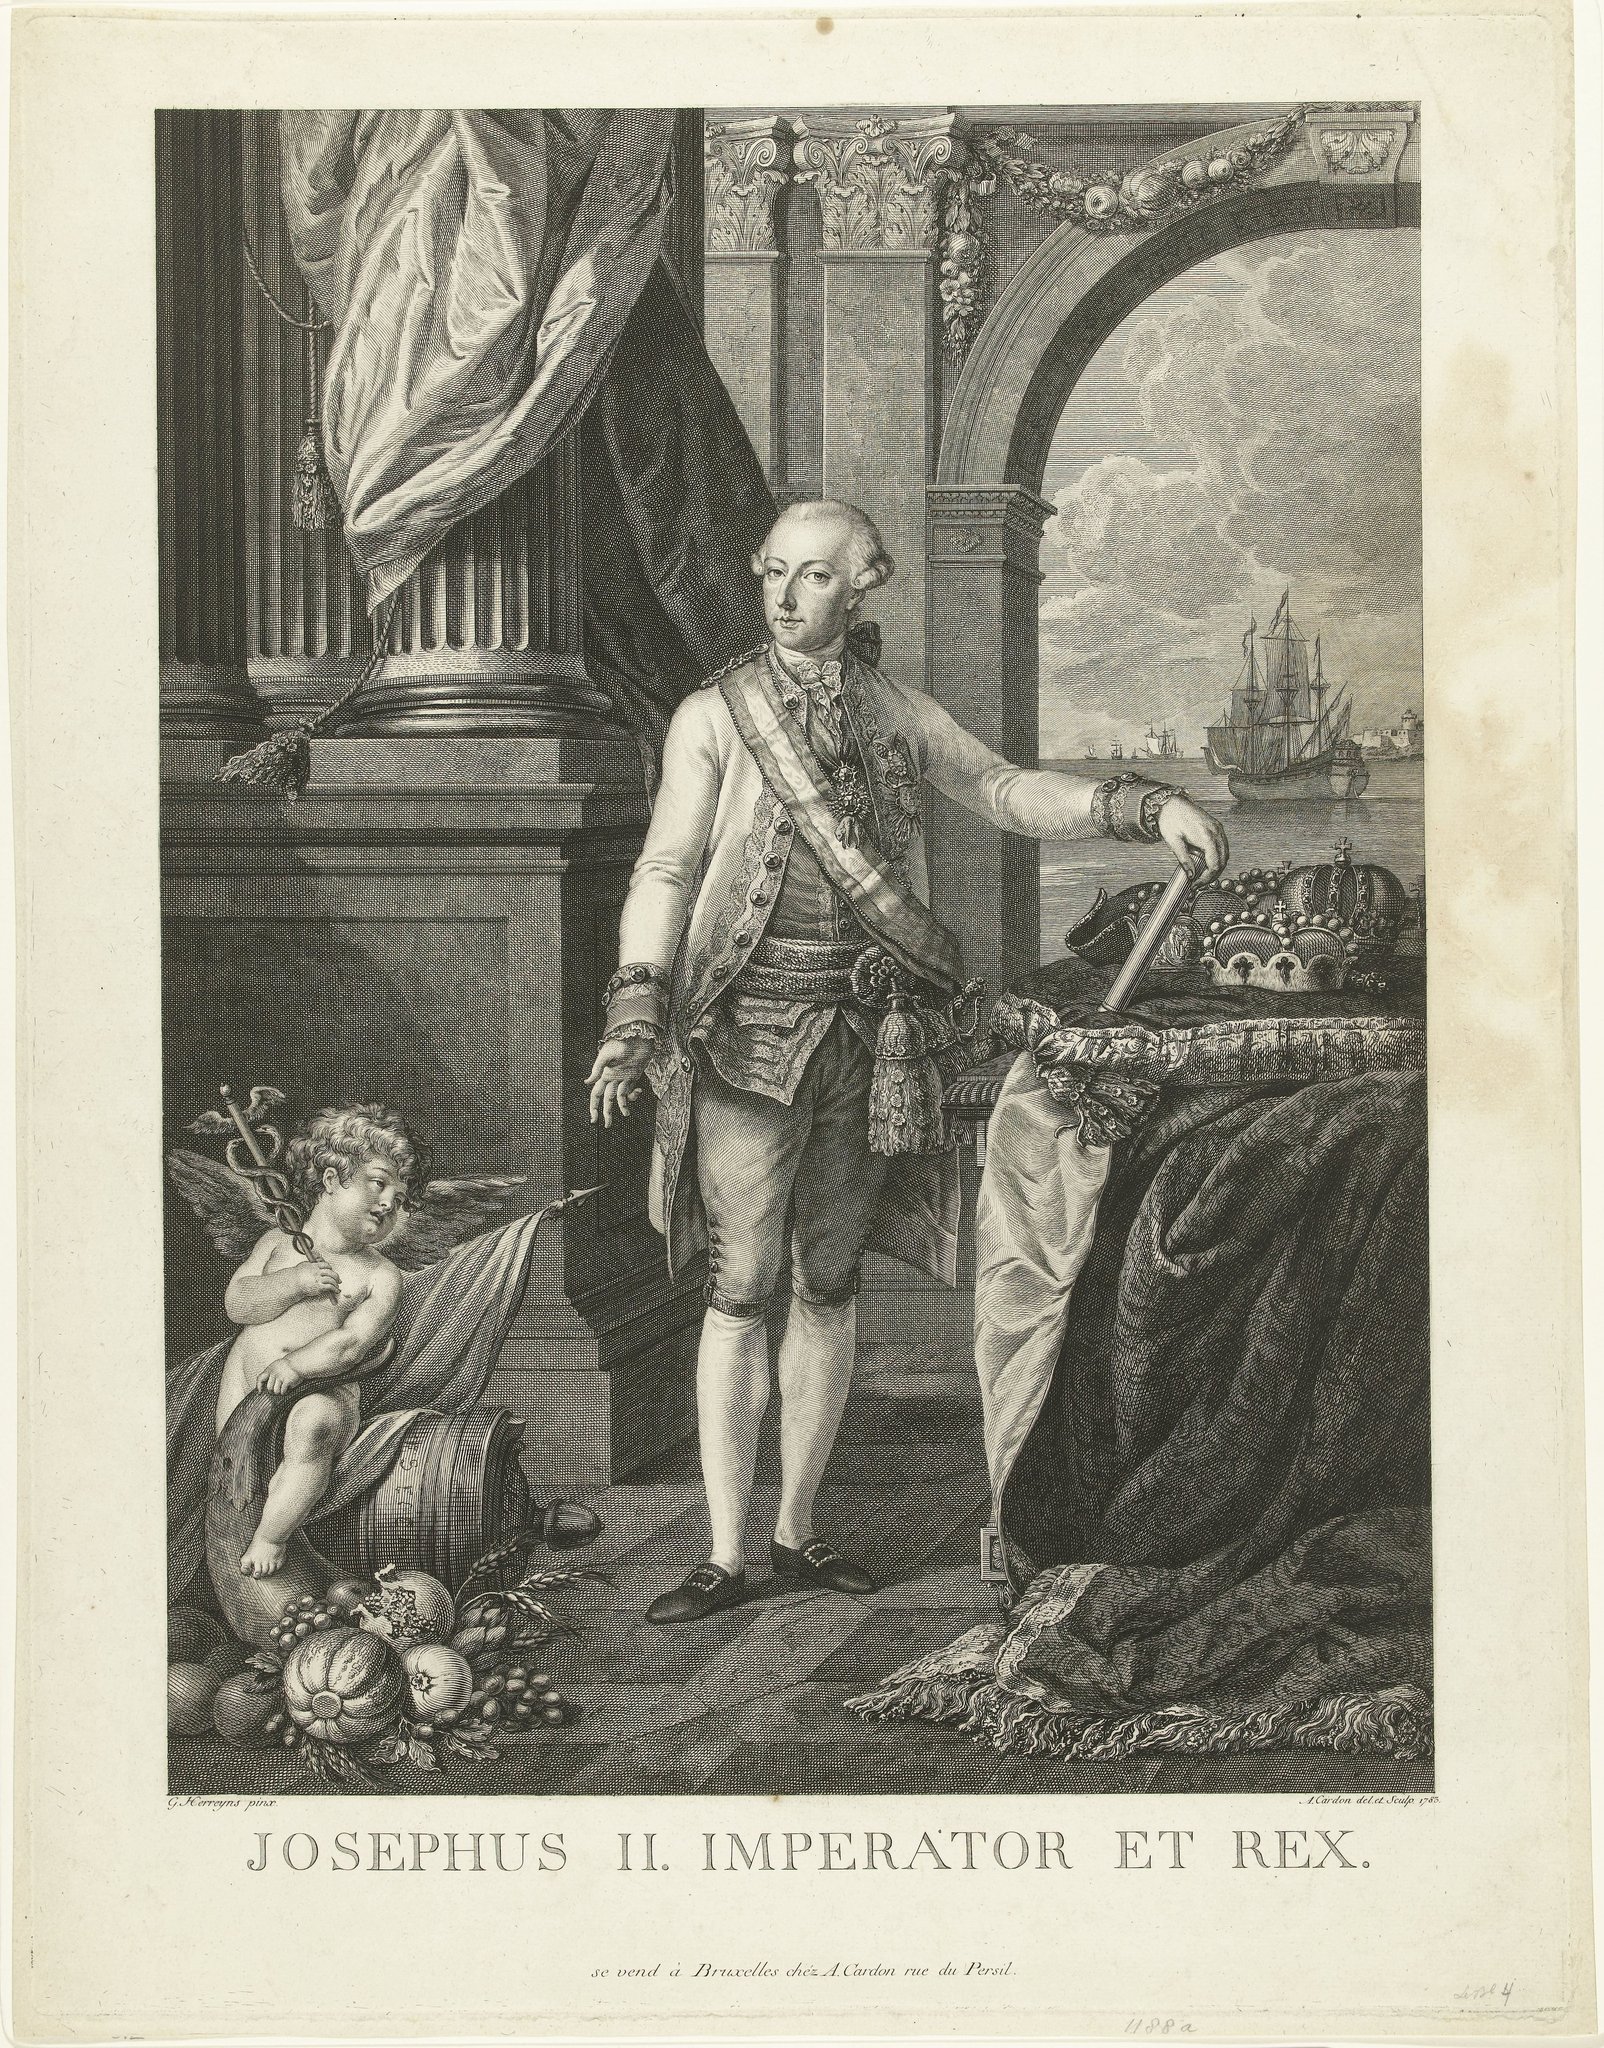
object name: print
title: Portret van de Duitse keizer Jozef II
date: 1783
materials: paper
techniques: engraving, etching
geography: brussels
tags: vienna, jozef ii (duits keizer), emperor, display of jewels, etc.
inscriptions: collector's mark: Lugt 2228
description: Portret van de Duitse keizer Jozef II in een rijk gedecoreerd vertrek met uitzicht op de zee. Op tafel liggen de kroonjuwelen, Jozef II duwt zijn commandostaf in een kussen. Links voor een putto met een esculaap en een hoorn des overvloeds die zit op een kruitvat.